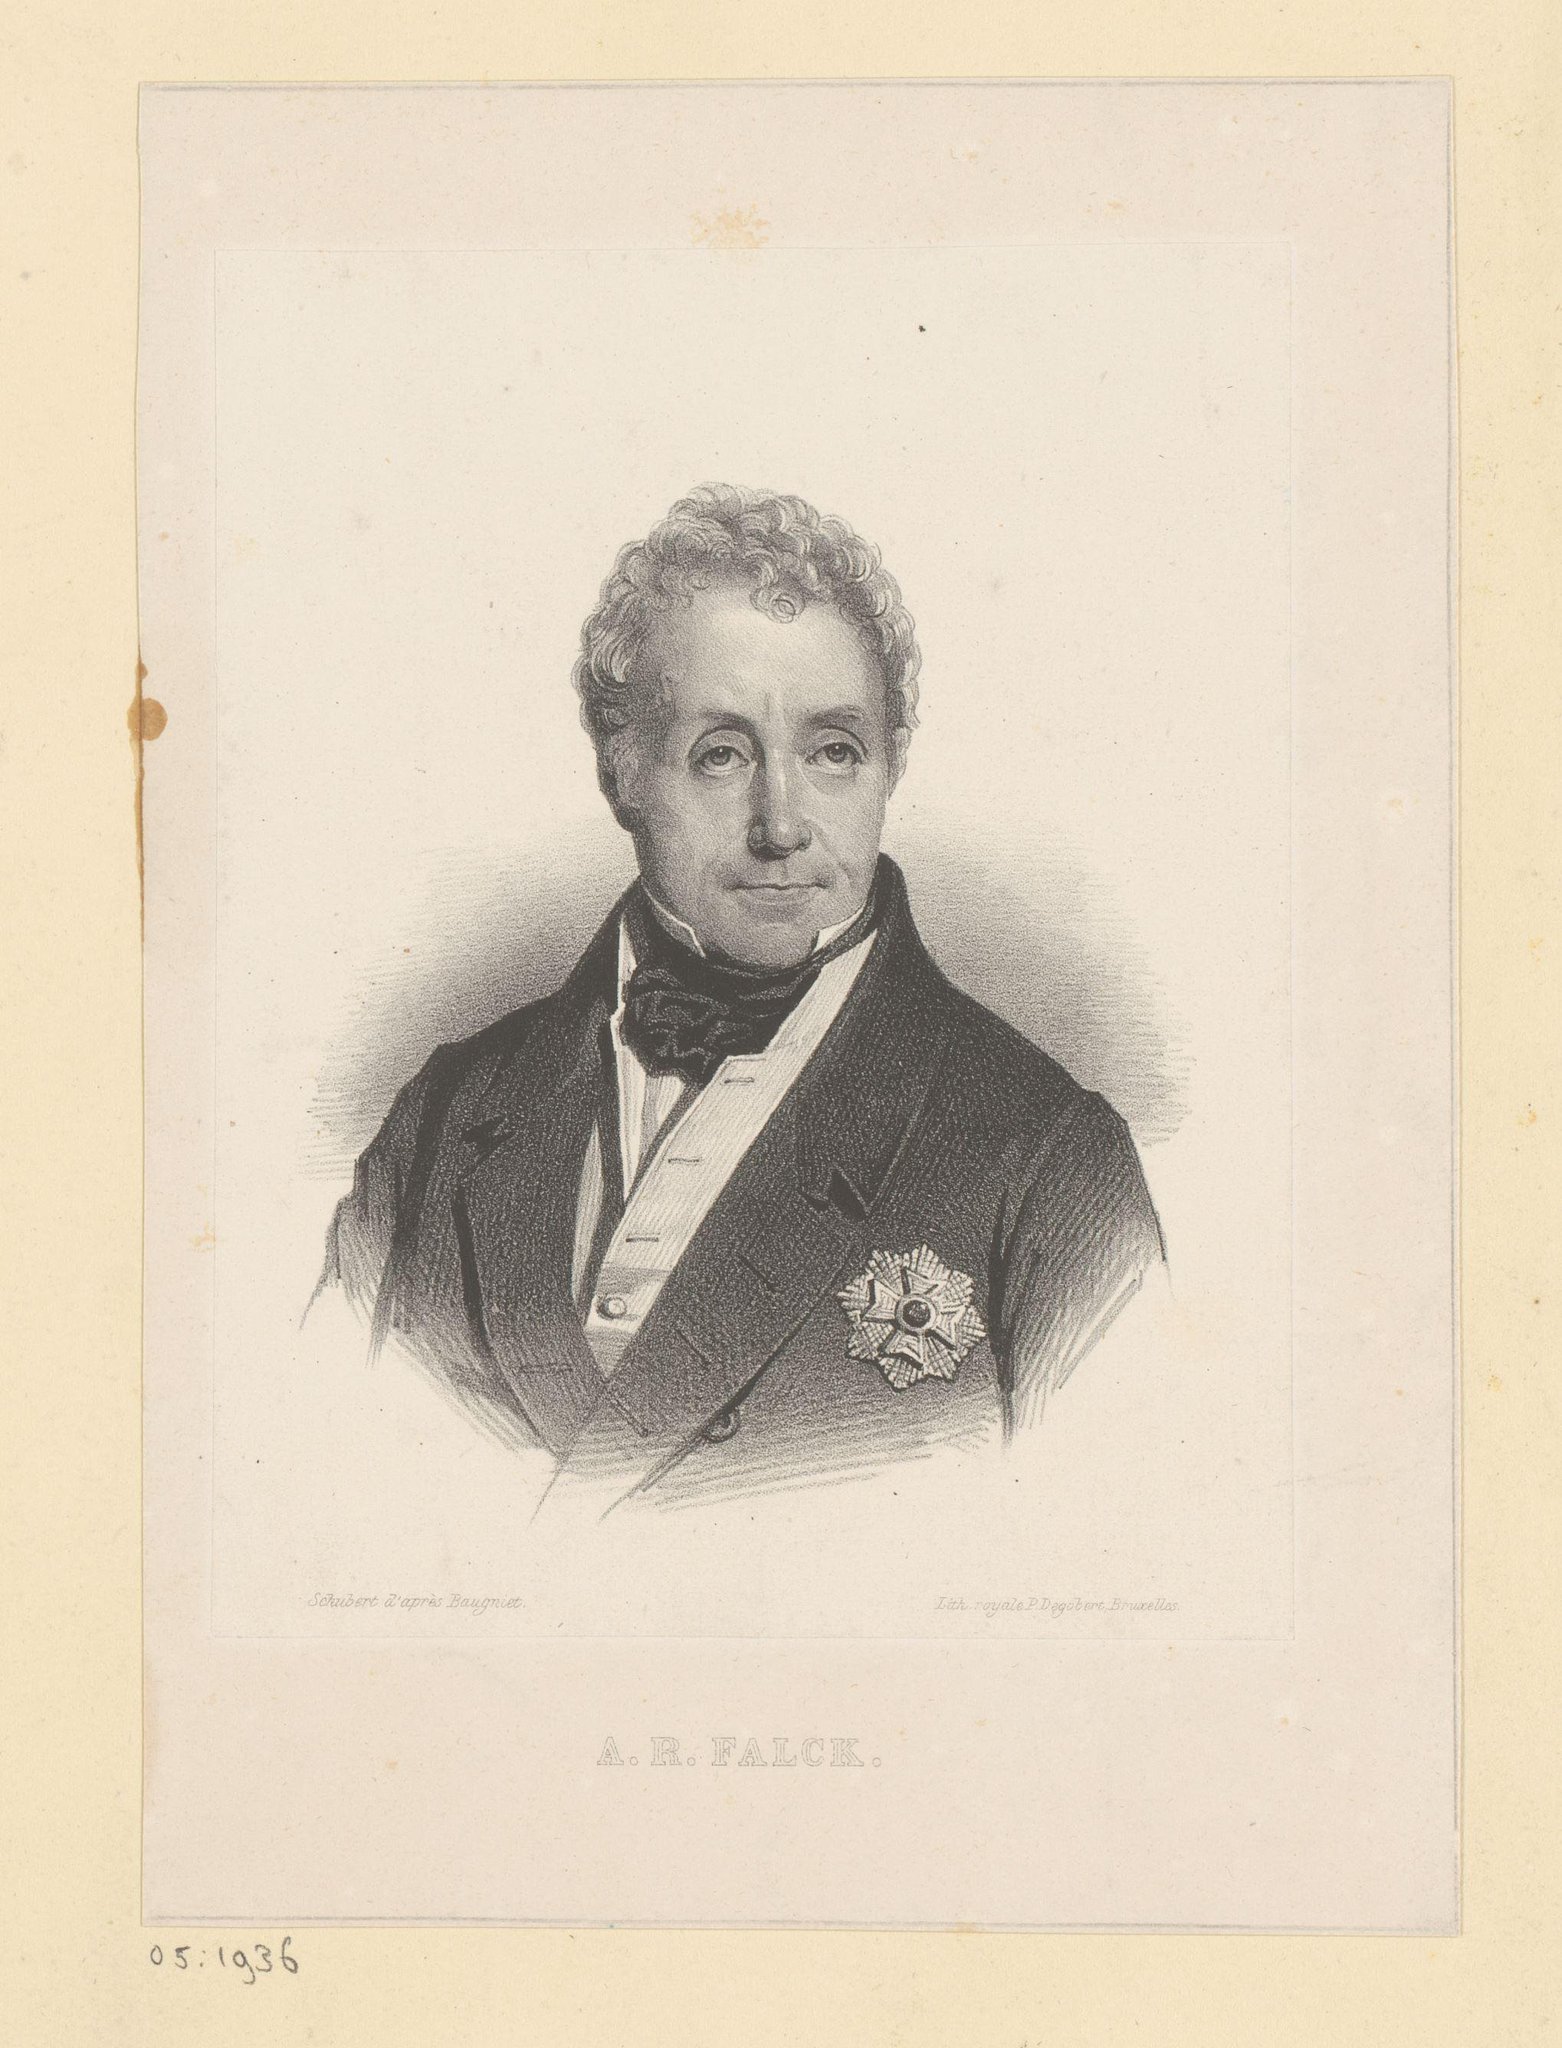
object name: print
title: Portret van Anton Reinhard Falck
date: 1826-1844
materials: paper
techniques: lithograph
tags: utrecht, brussels, anton reinhard falck, historical persons, politician, e.g. party leader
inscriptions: collector's mark: Lugt 2228